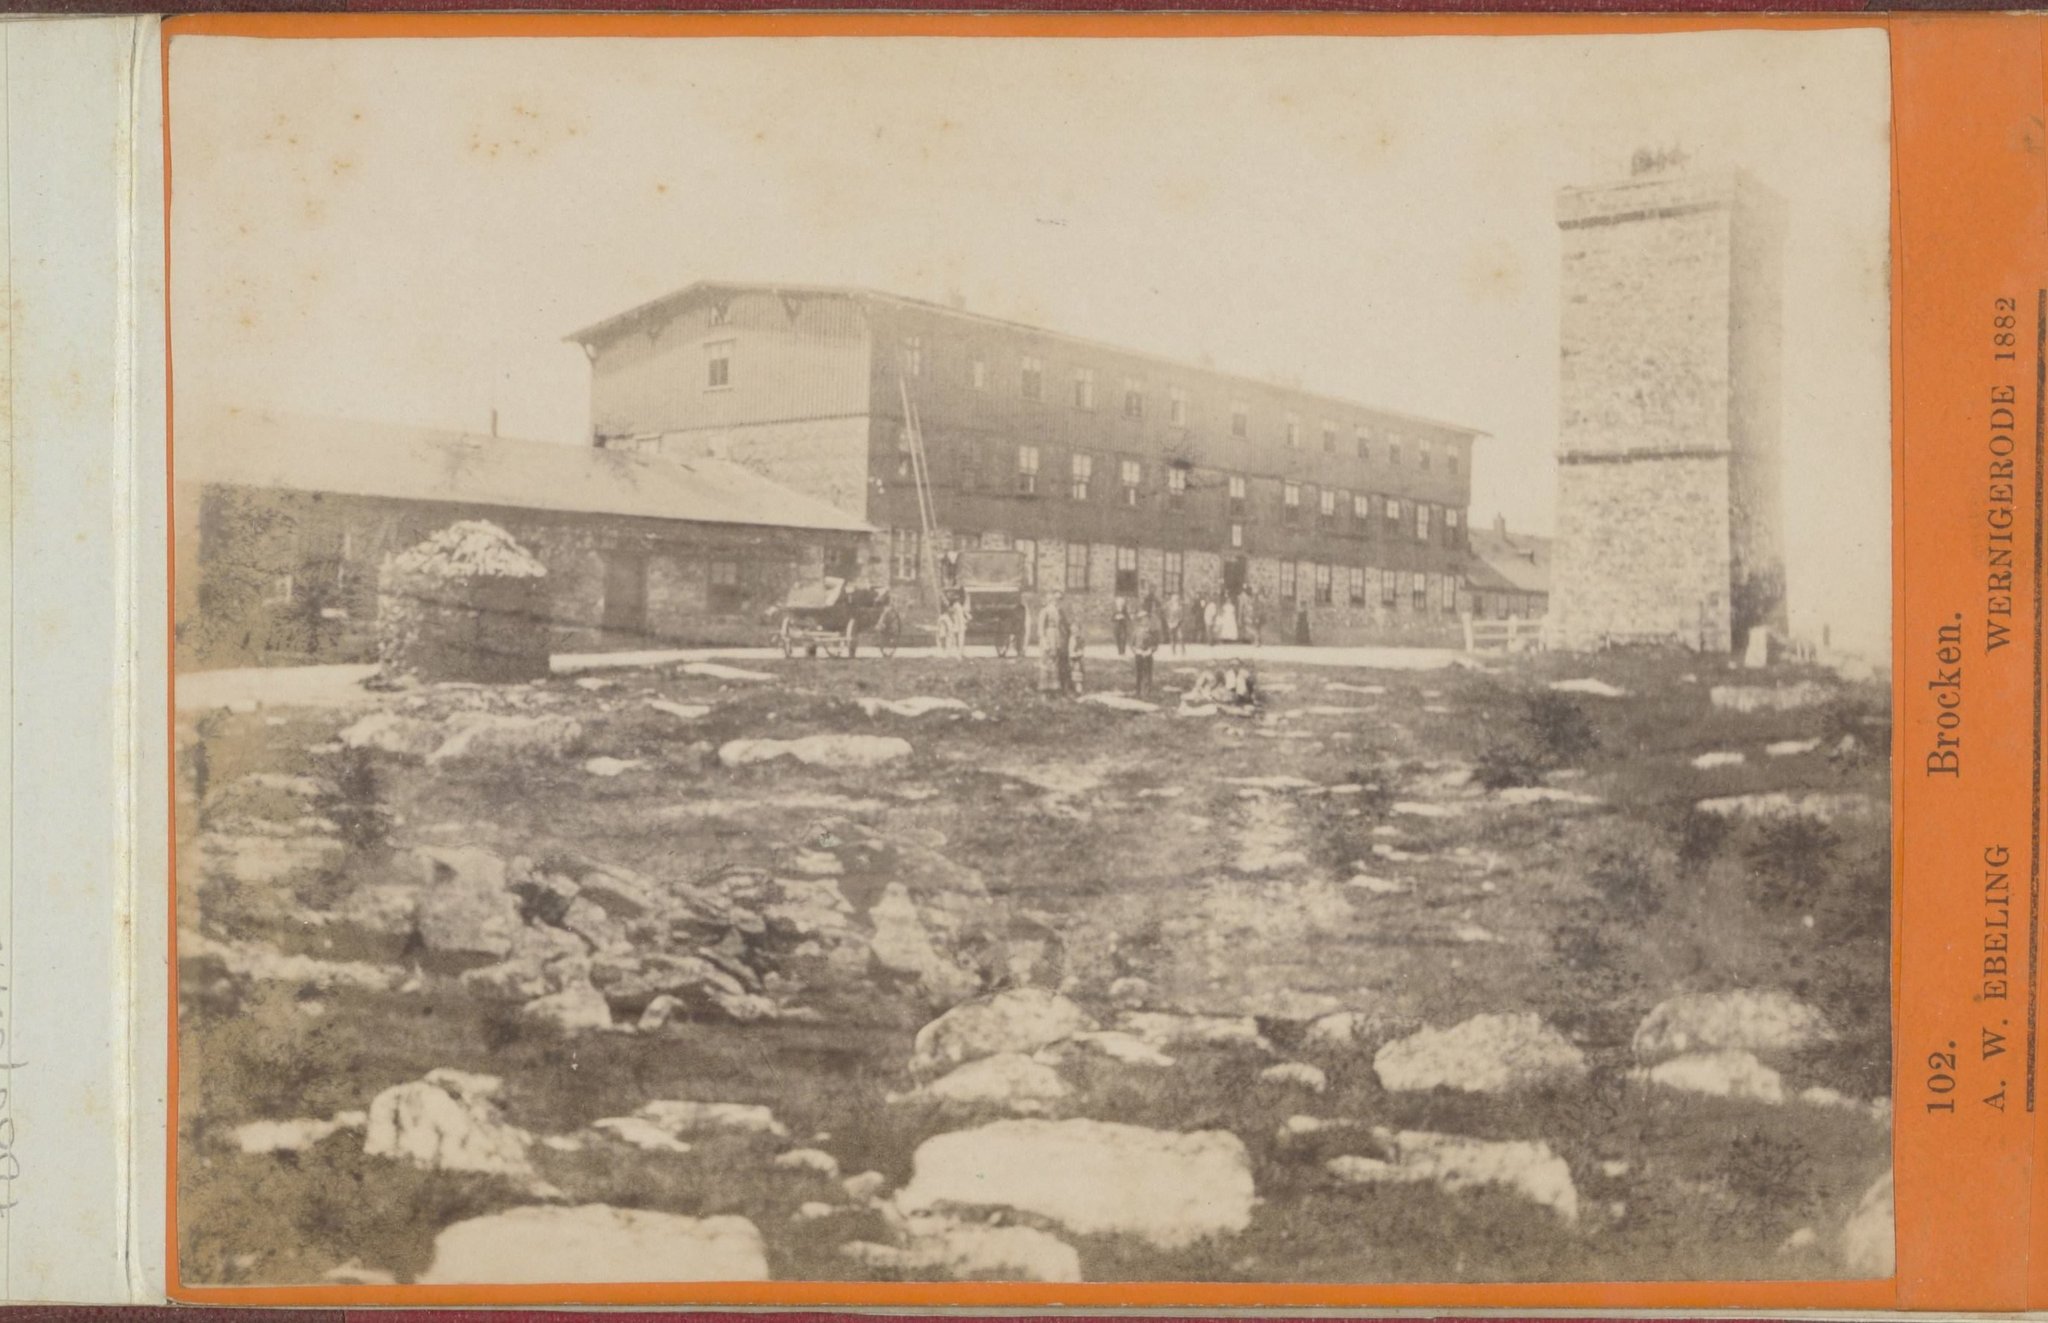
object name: cabinet photograph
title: Gebouwen op de berg Brocken in de Harz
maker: albert wilhelm ebeling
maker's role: fotograaf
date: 1882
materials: cardboard, paper, photographic support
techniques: albumen print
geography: brocken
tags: travelling; tourism, exterior ~ representation of a building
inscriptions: number: ‘102’, name: ‘Alb. Wilh. Ebeling, Wernigerode / Photographische Anstalt für Architekturen, Reproductionen u. Landcshaften.’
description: Onderdeel van Album met 38 foto's van een reis door de Harz.